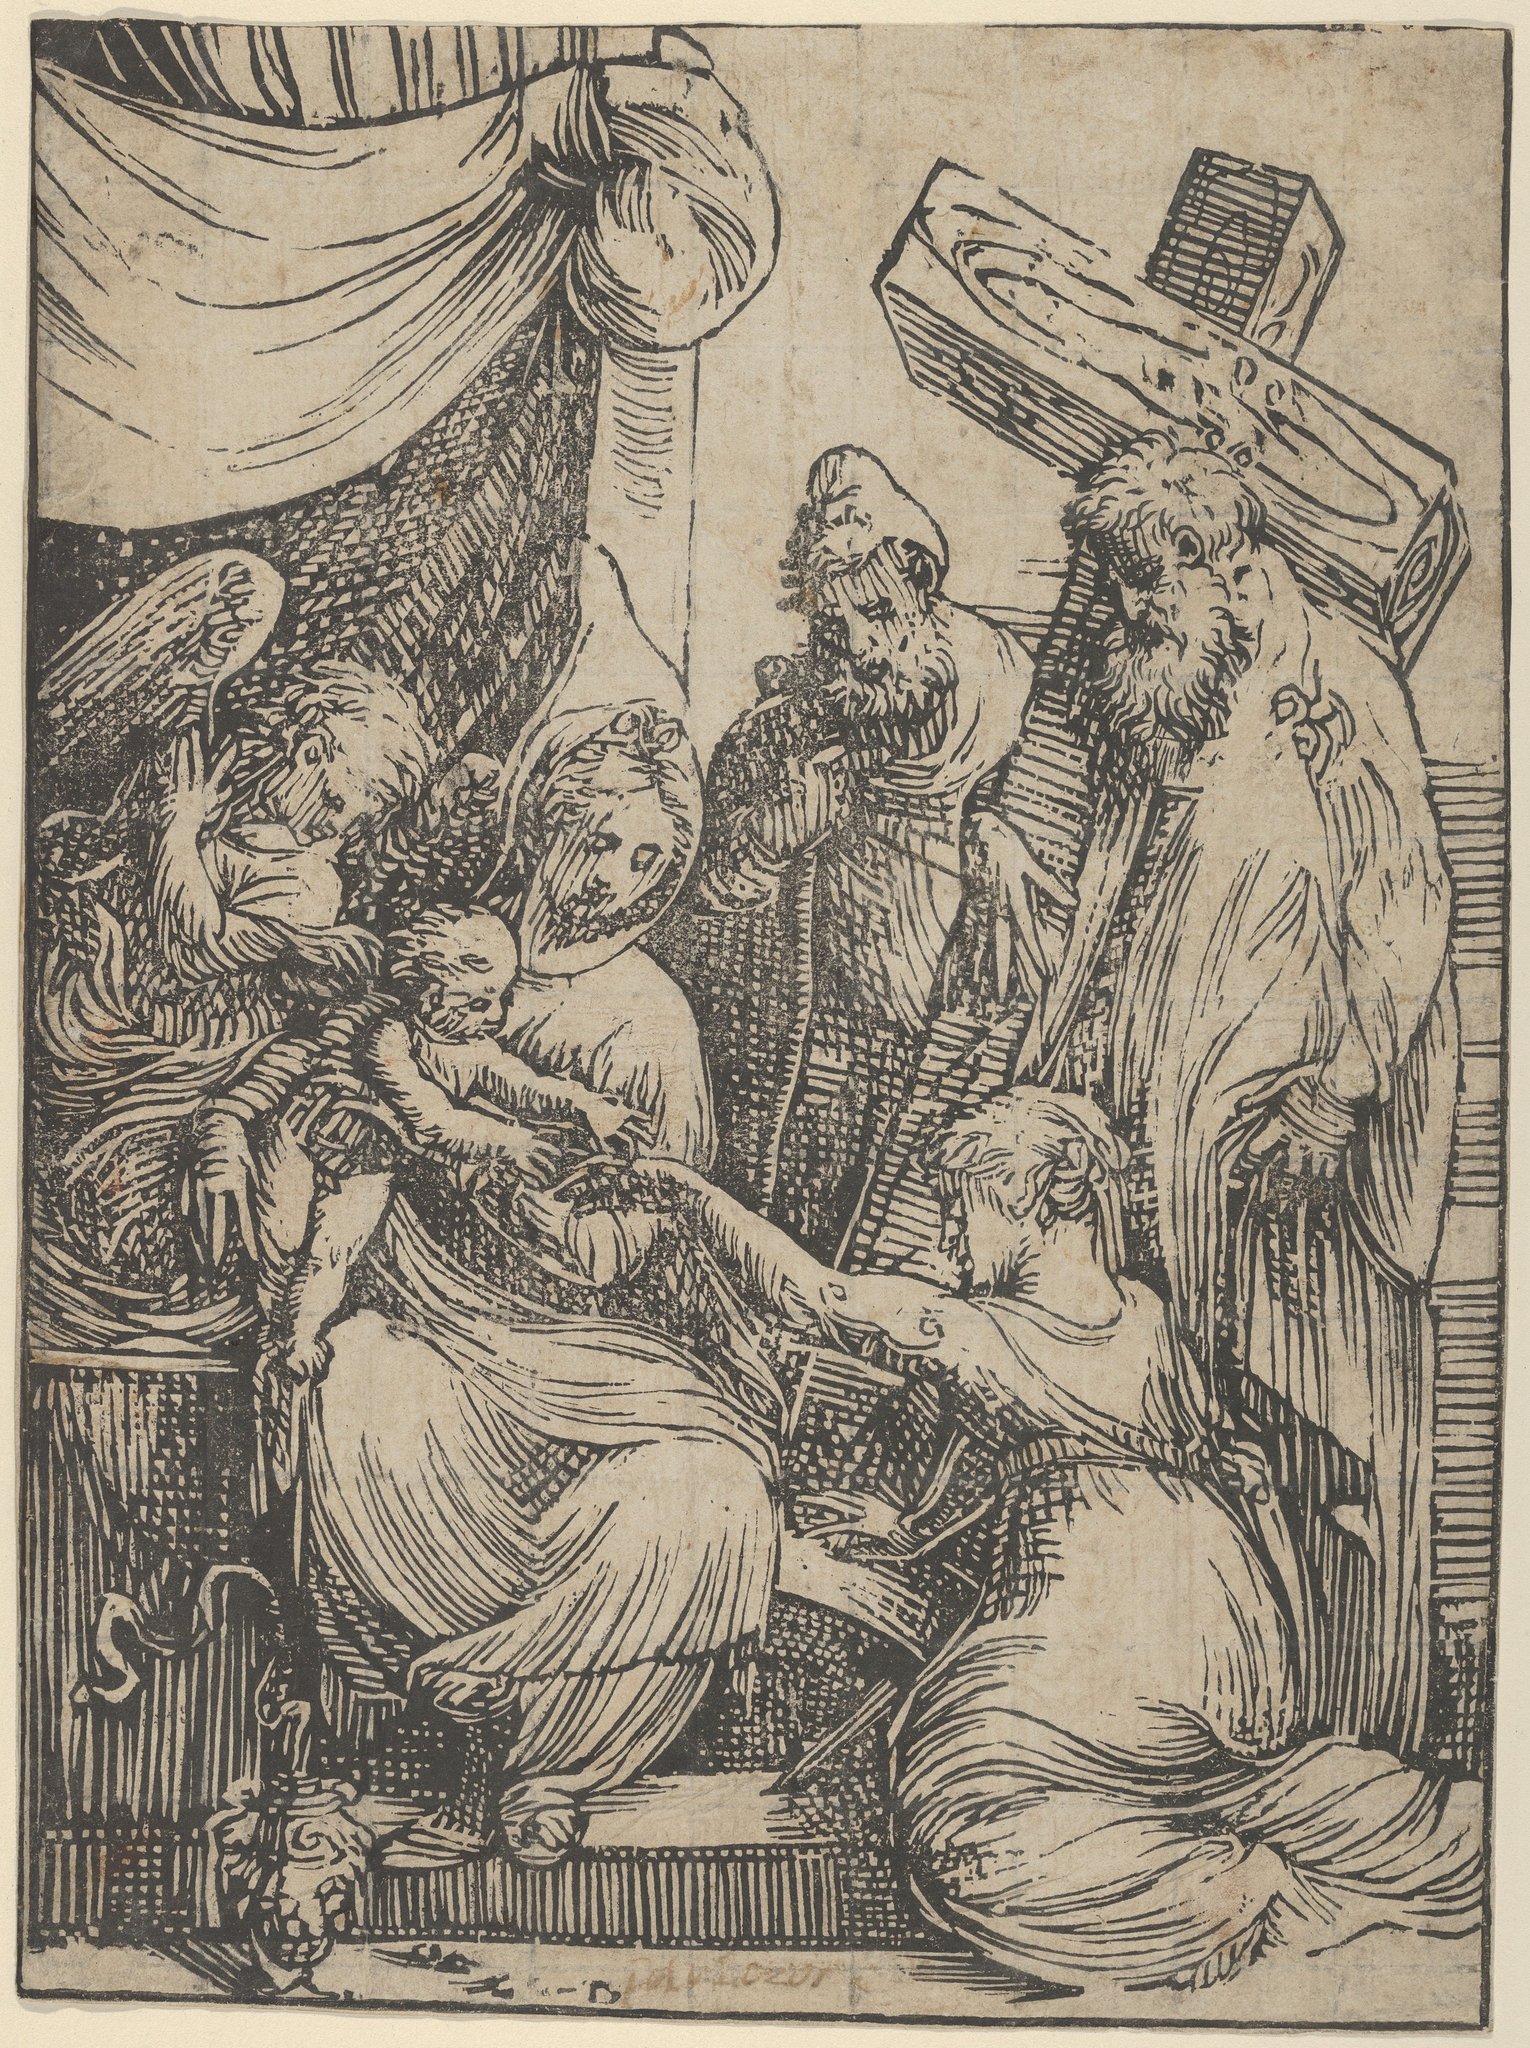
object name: print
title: The marriage of Saint Catherine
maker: andrea schiavone (andrea meldola)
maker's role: artist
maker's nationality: italian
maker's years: 1510-1563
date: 1550-1560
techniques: woodcut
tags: human figures,angels,saint catherine,cross